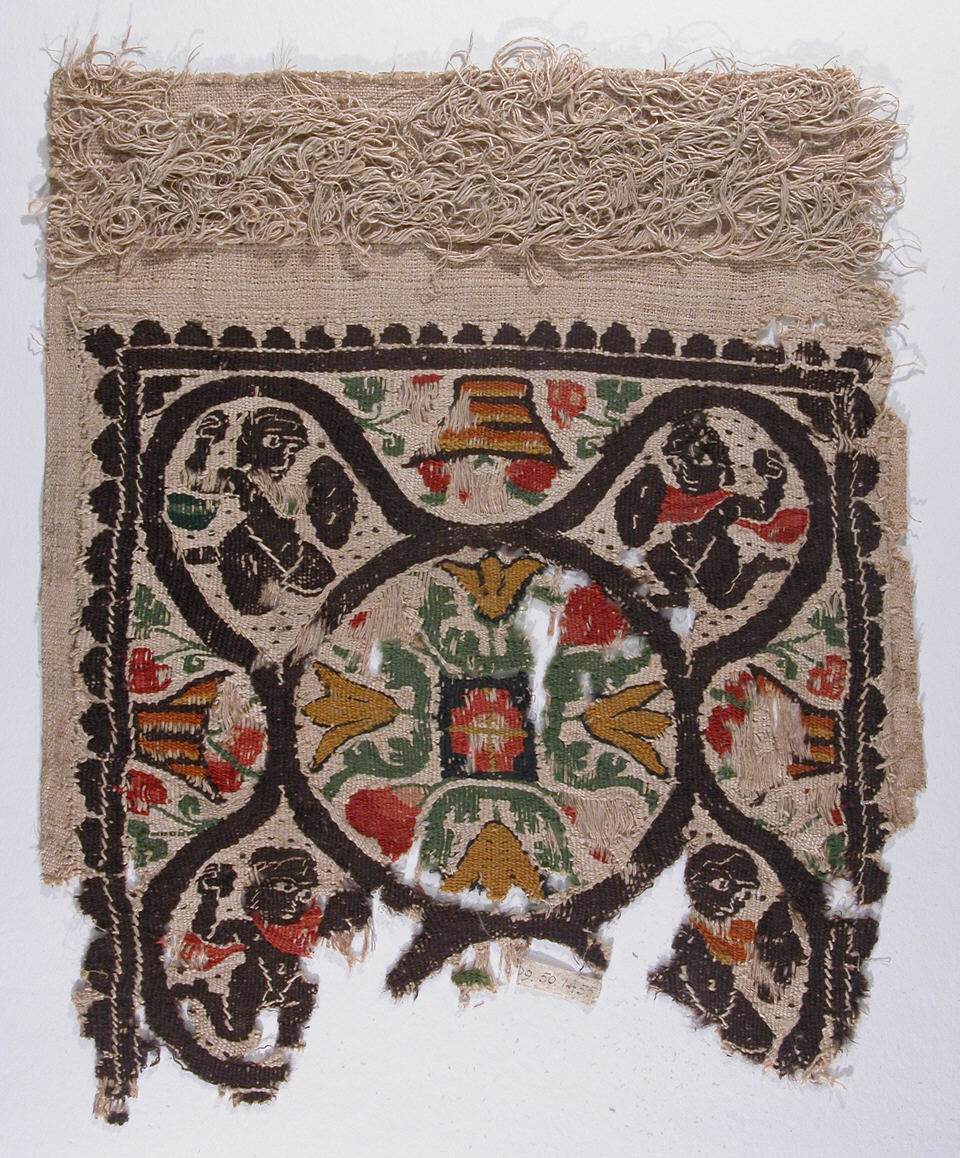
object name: panel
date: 301-500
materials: linen, wool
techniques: embroidery, weave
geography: egypt